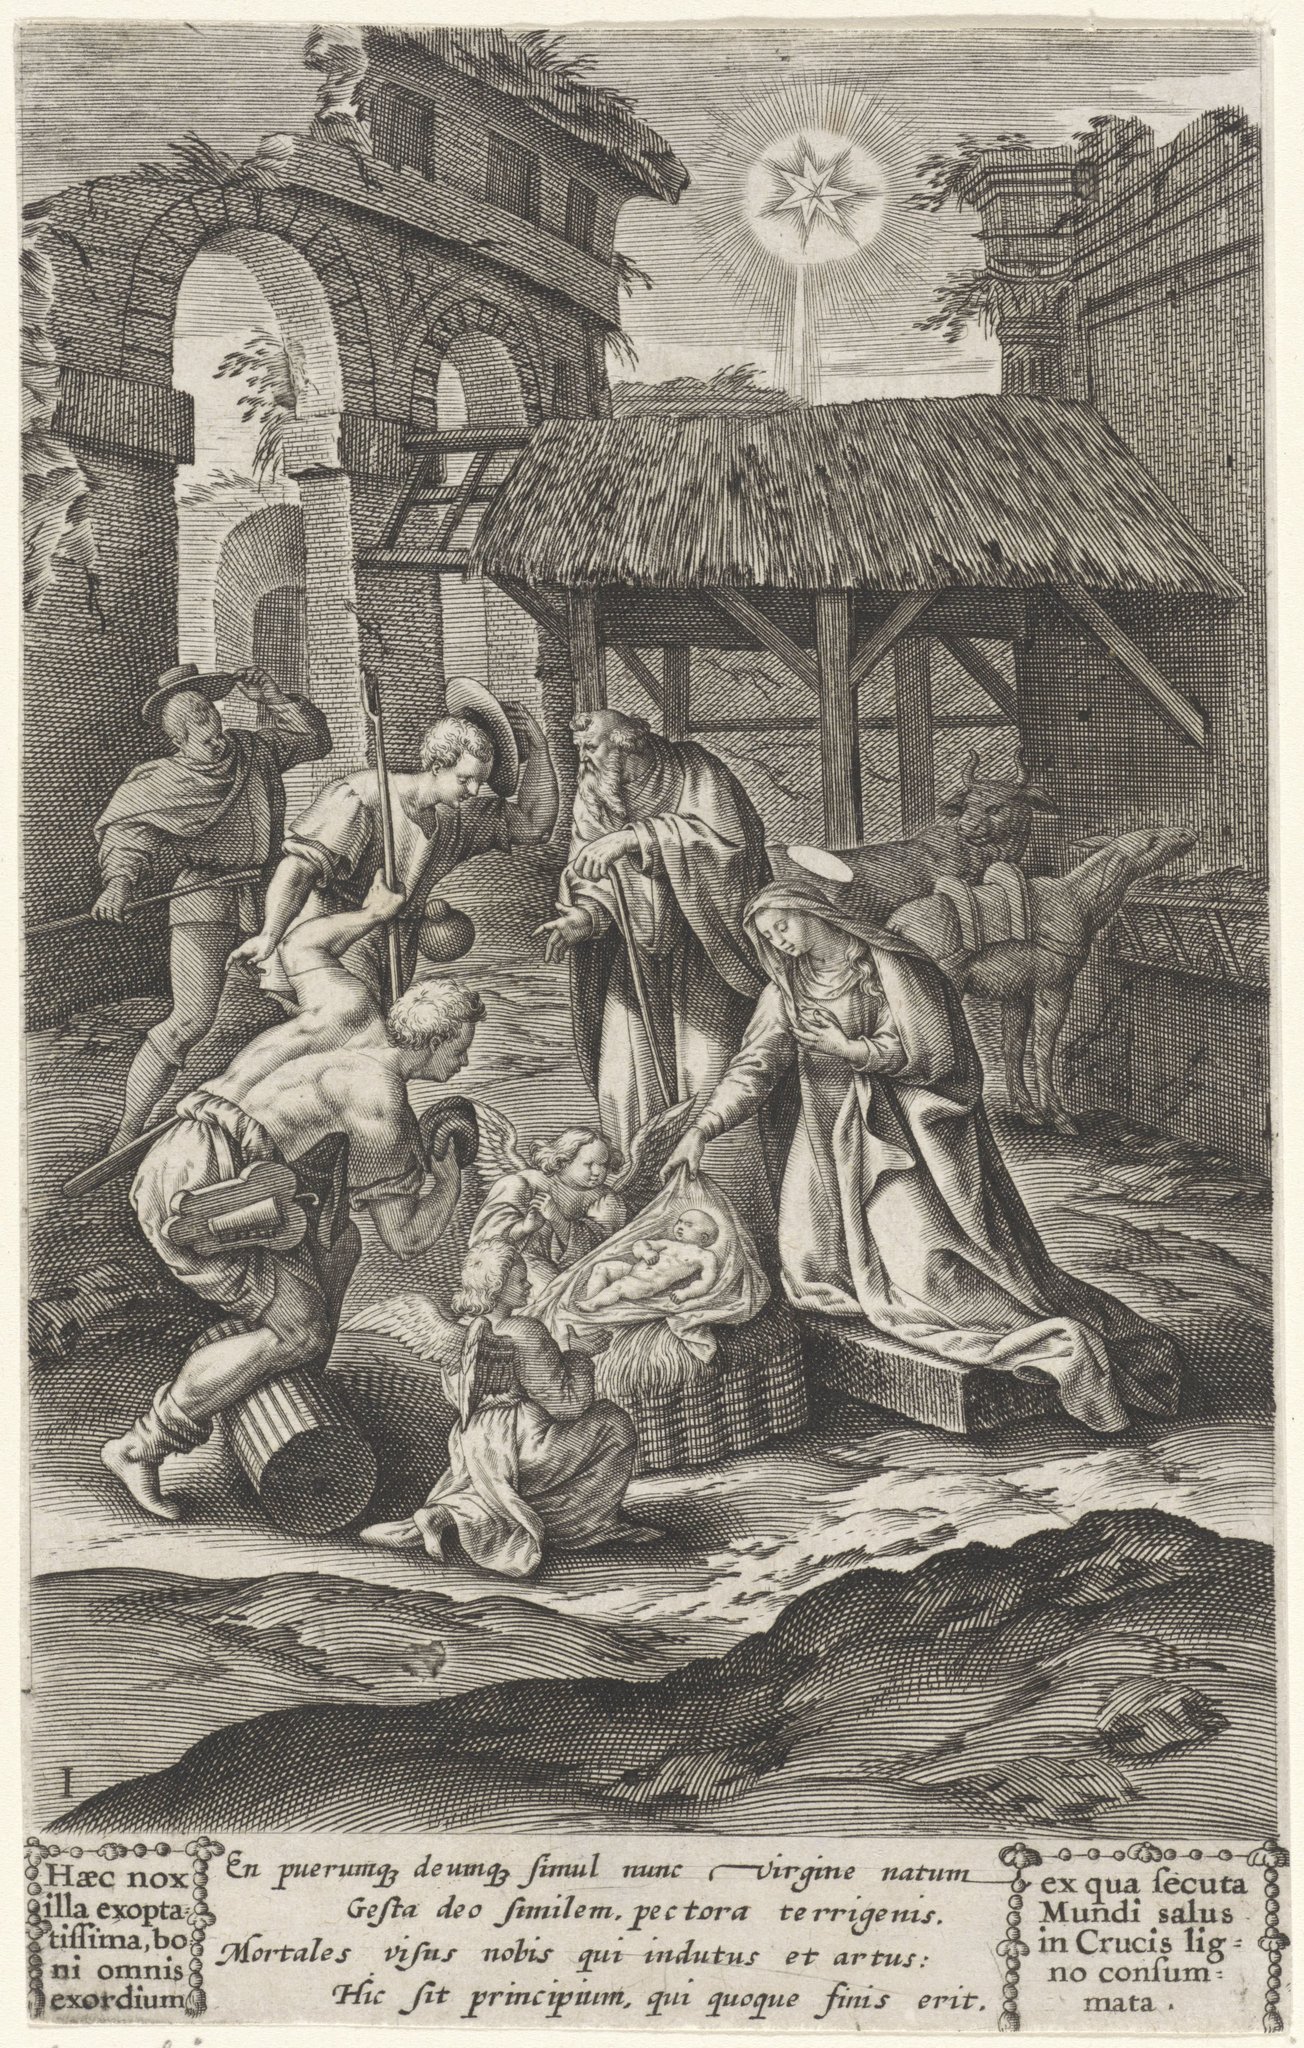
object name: print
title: Dominicæ Passionis Mysteria Typicis Advmbrationibvs Adamussim Effigiata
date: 1583-1587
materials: paper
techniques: engraving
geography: antwerp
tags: adoration of the christ-child by the shepherds; mary and joseph present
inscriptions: collector's mark: Lugt 2228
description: Prent gebruikt in: Thesaurus sacrarum historiaru[m] veteris (et novi) testame[n]ti, elega[n]tissimis imaginibus expressu[m] excelle[n]tissimoru[m] in hac arte viroru[m] opera : nu[n]c primu[m] in luce[m] editus. Antwerpen: Gerard de Jode, 1585.